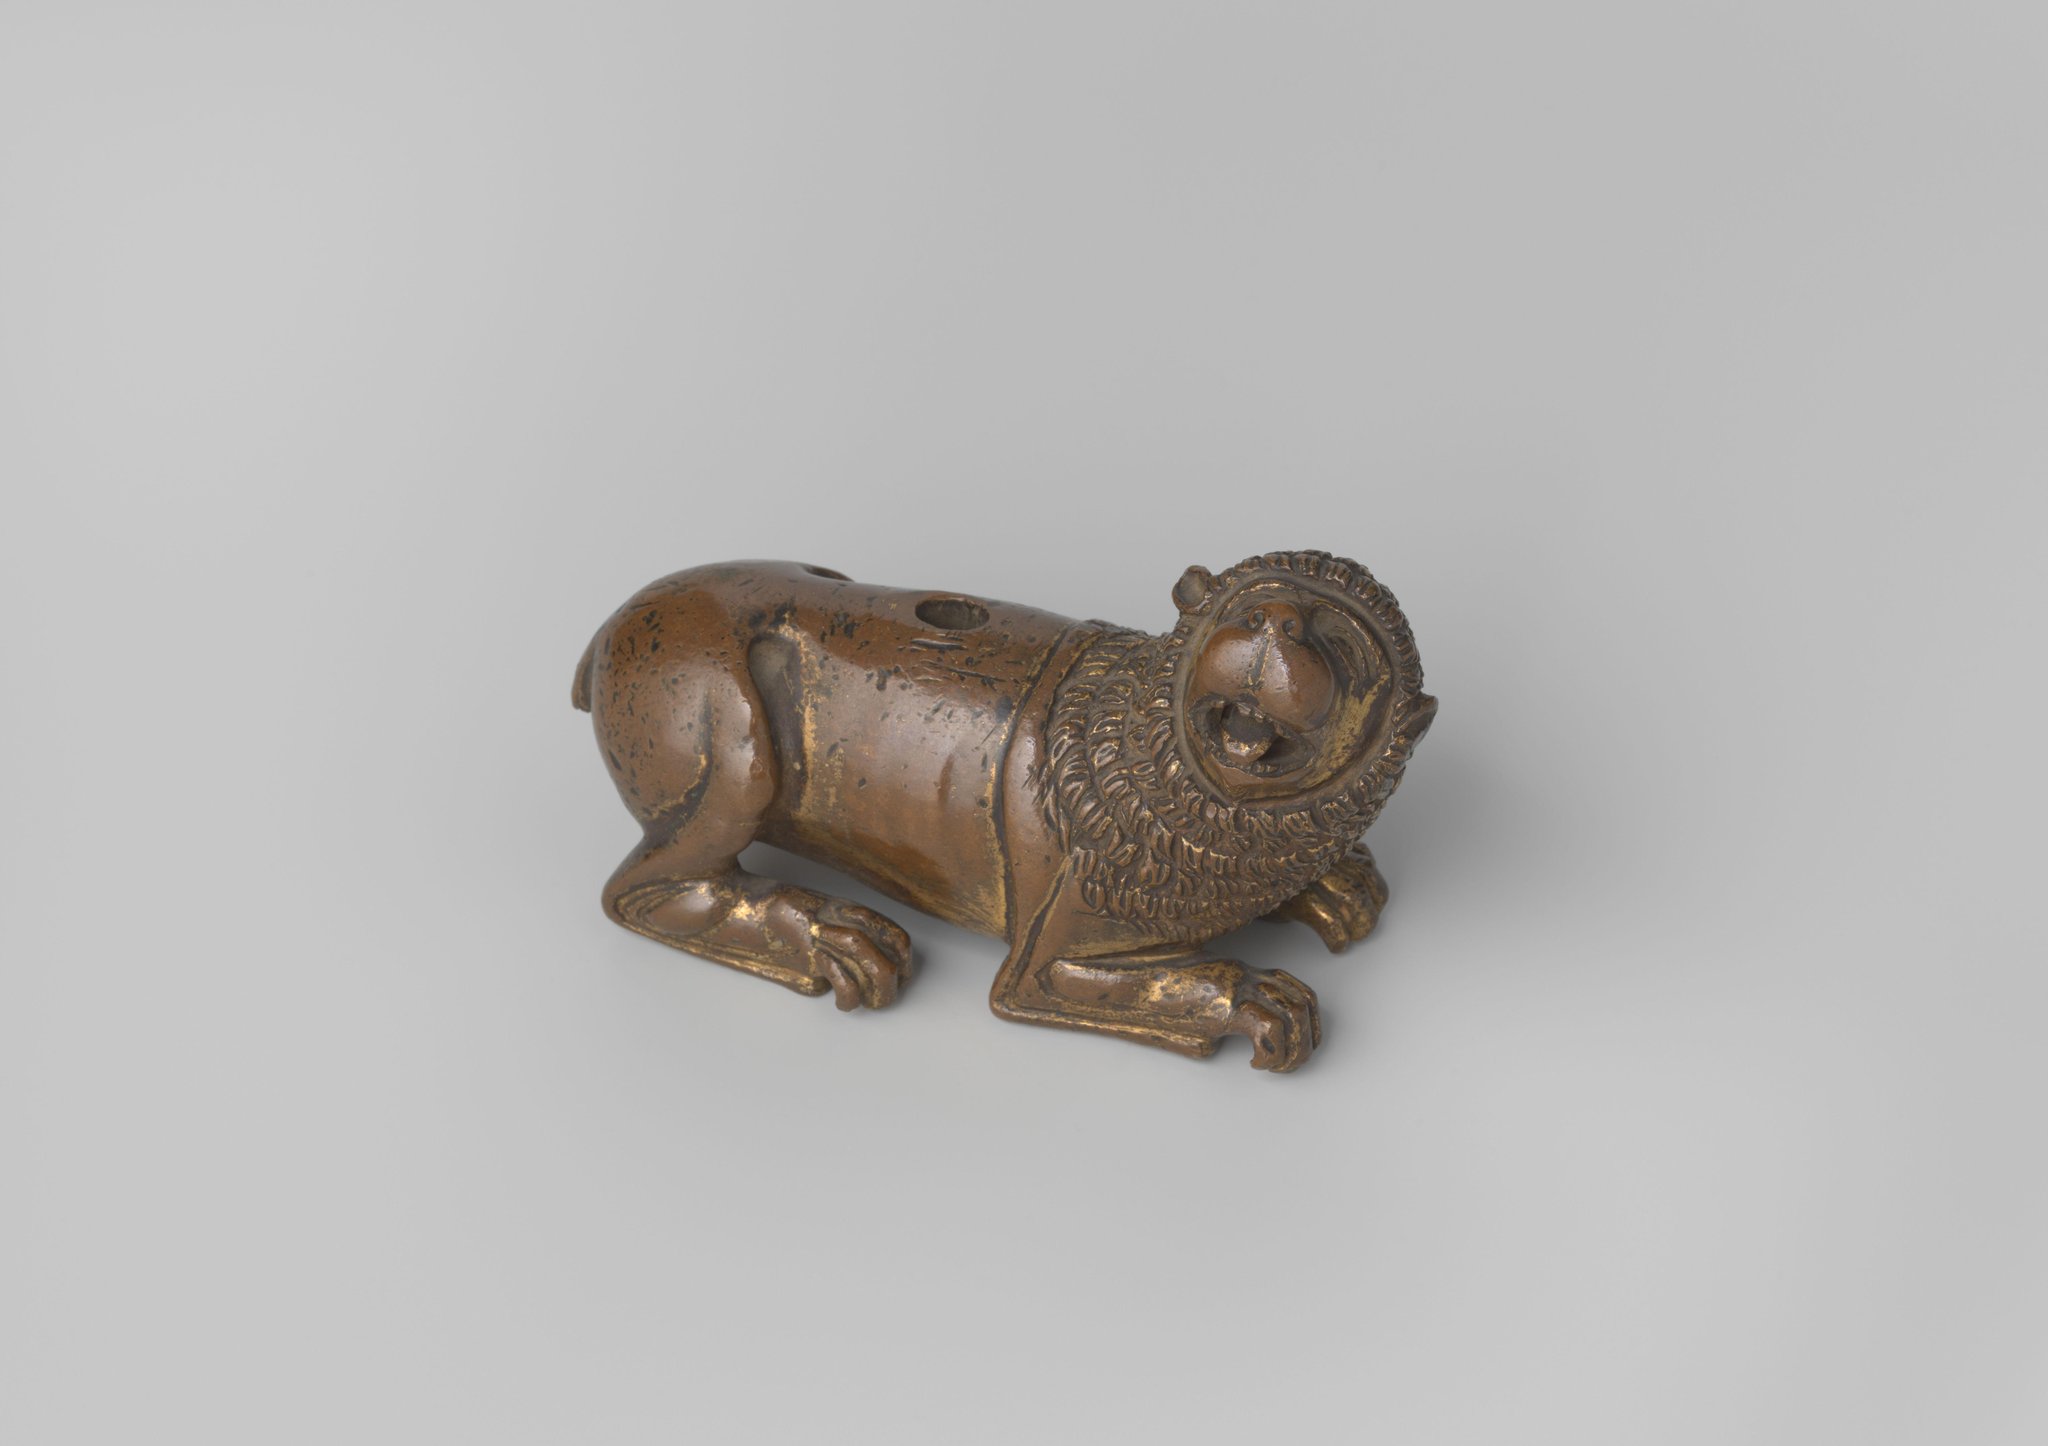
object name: sculpture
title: Liggende leeuw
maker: Anonymous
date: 1150-1200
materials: bronze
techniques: casting, metalworking, gilding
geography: meuse area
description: Lion, base of a reliquary (?). Gilt bronze. Meuse area, c. 1150 - 1200.